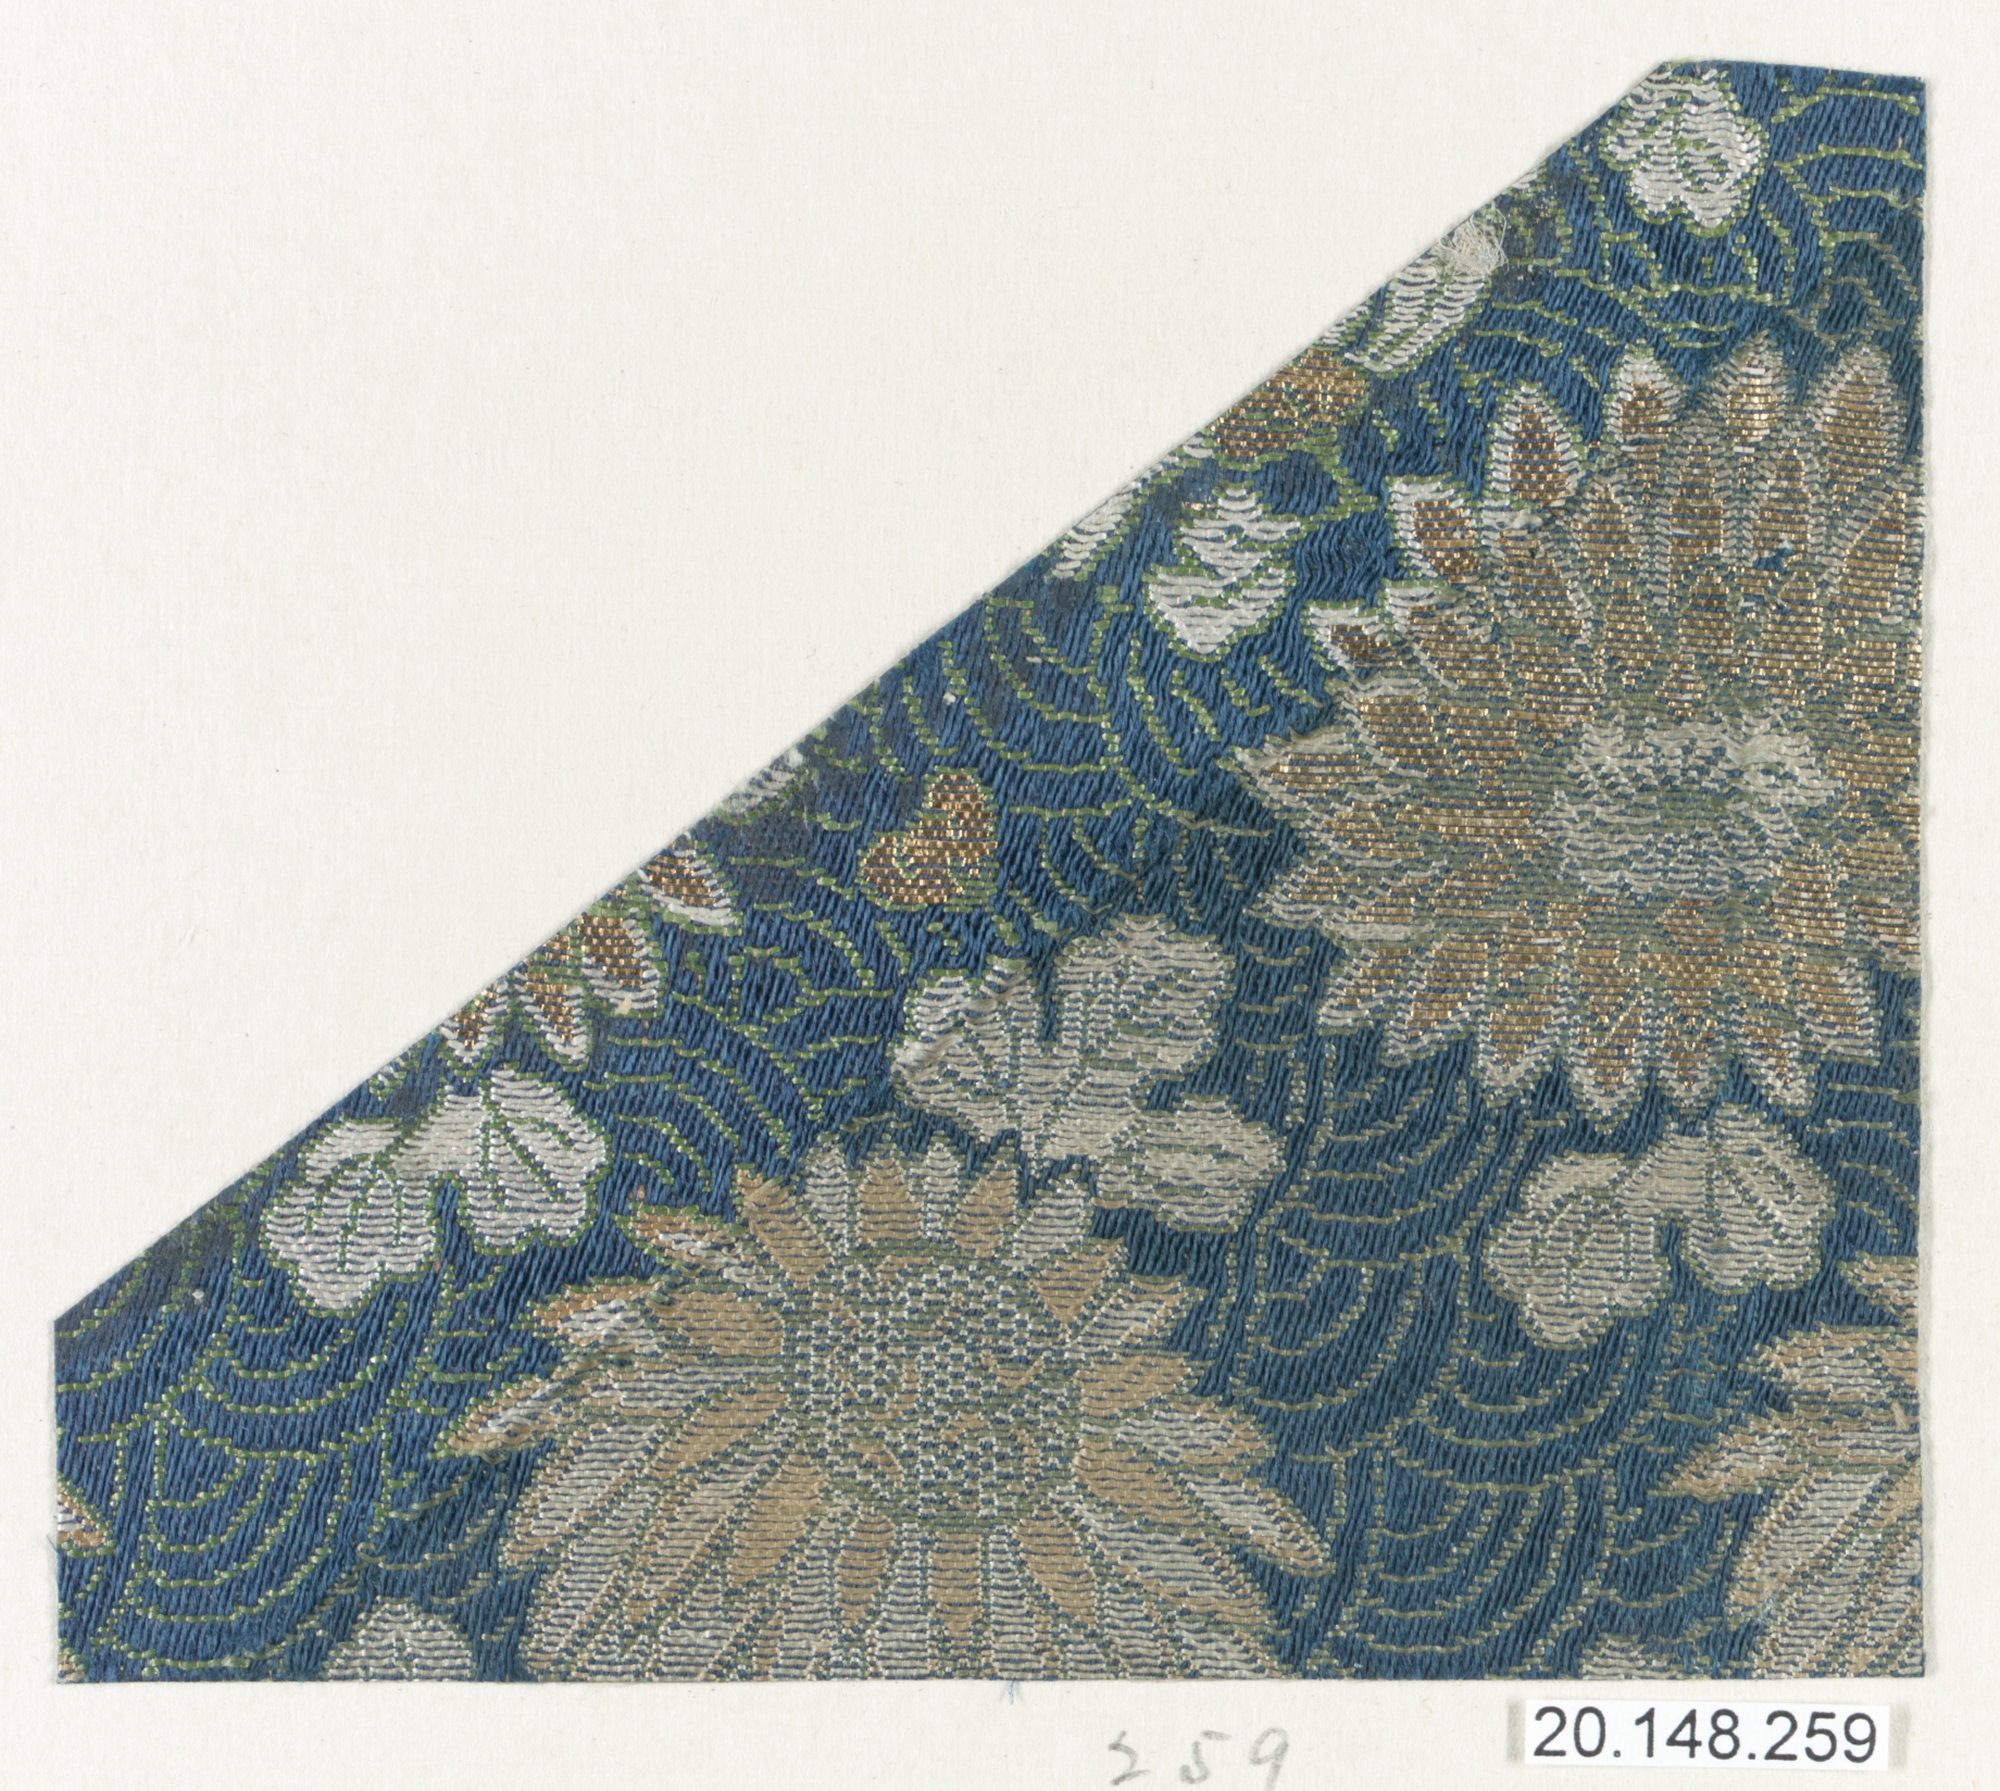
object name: piece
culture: japanese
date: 1701-1800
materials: silk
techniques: compound weave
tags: flowers